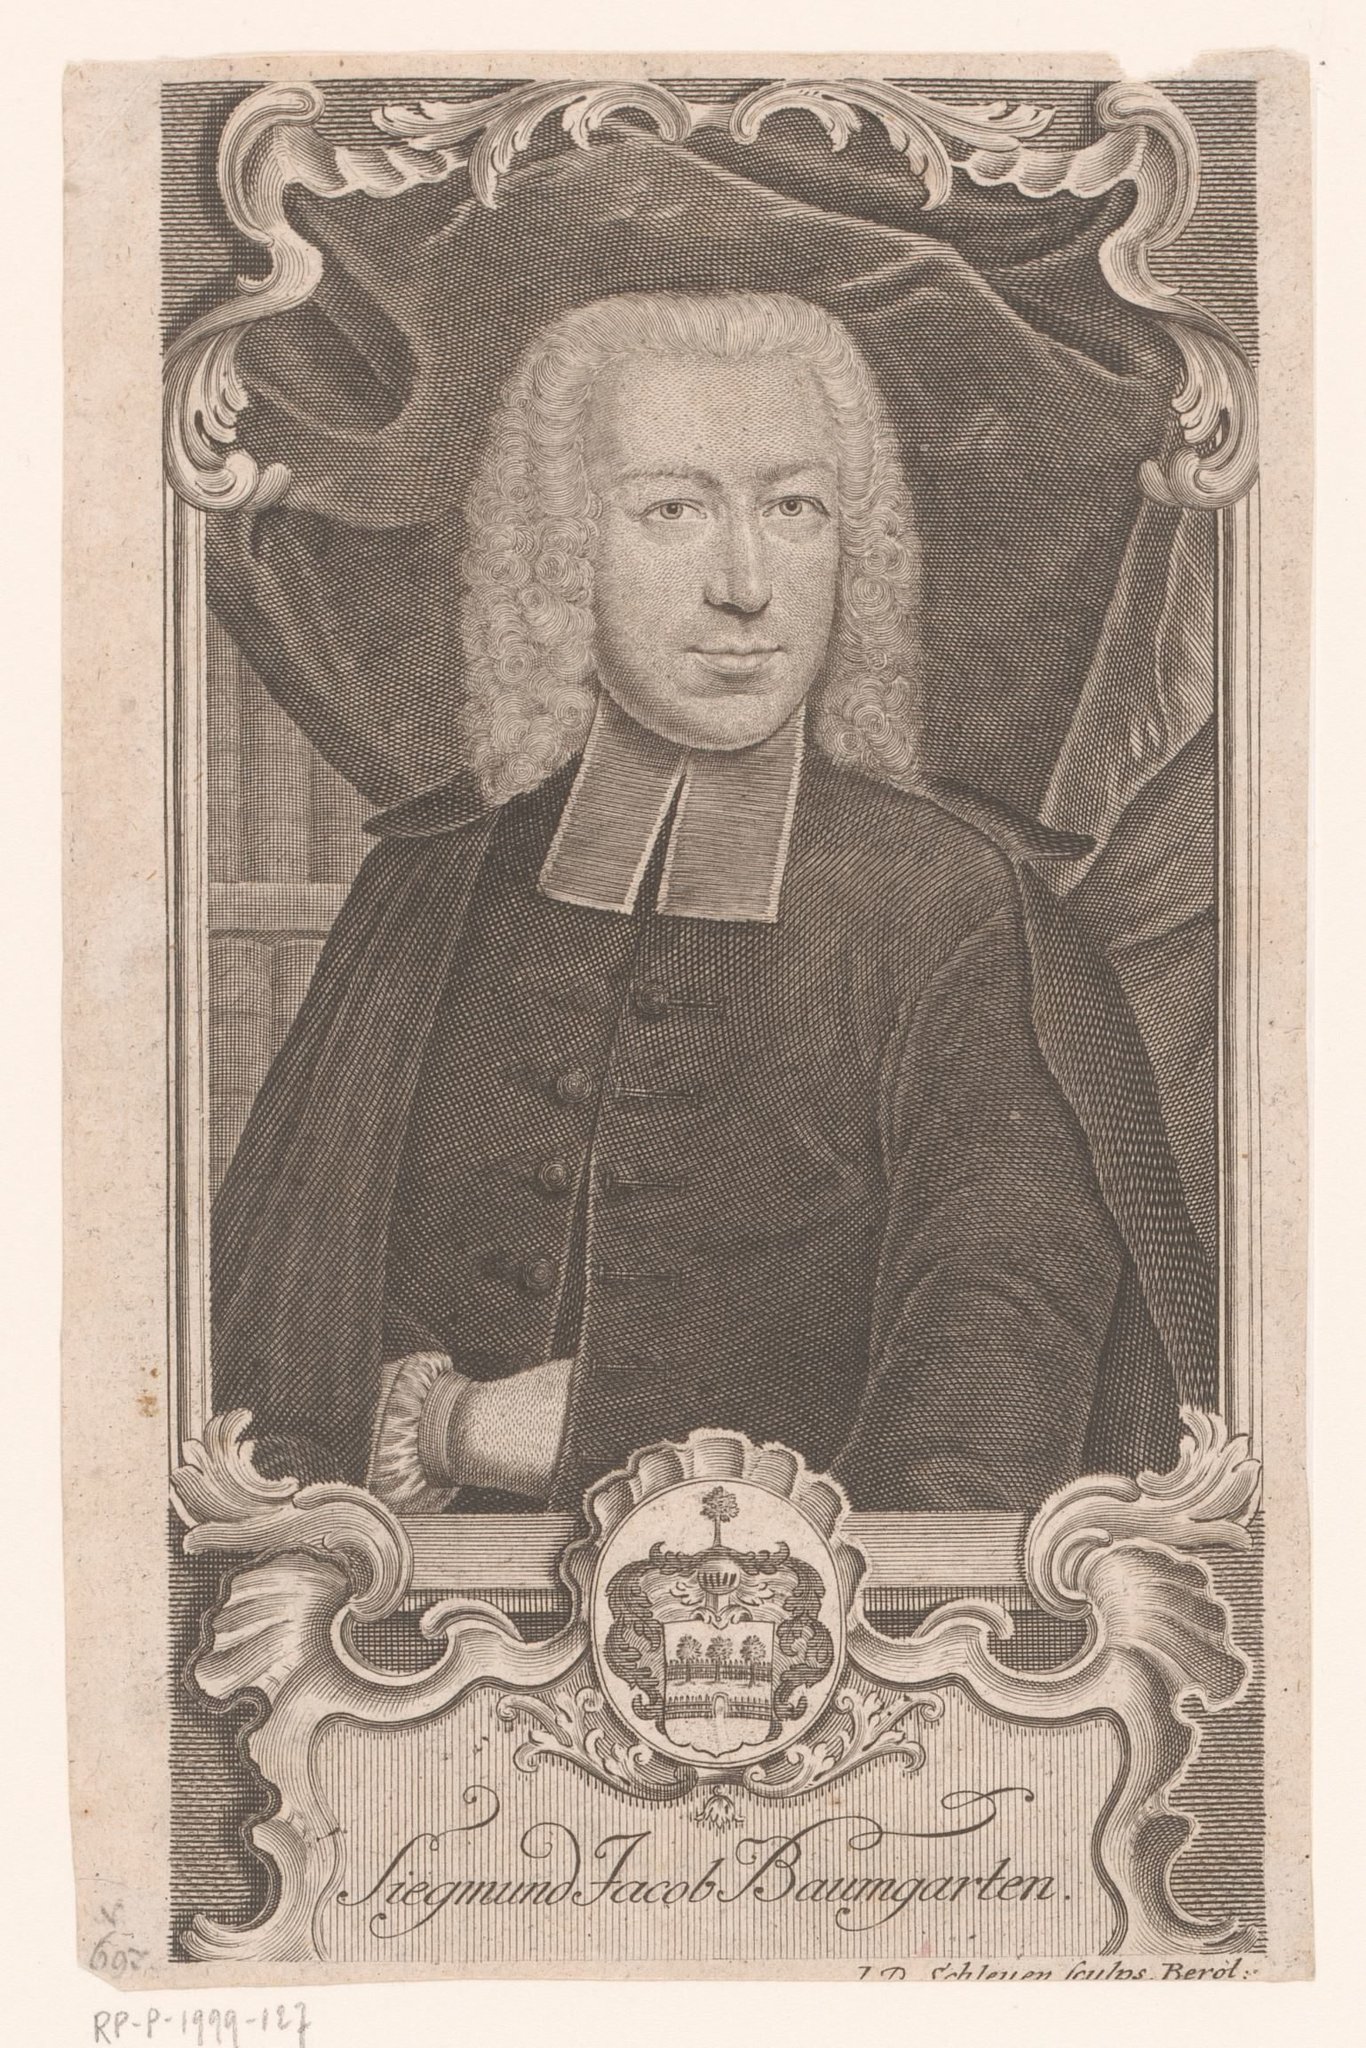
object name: print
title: Portret van Sigmund Jacob Baumgarten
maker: johann david schleuen (i)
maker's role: print maker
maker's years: 1711-1774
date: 1721-1771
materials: paper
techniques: engraving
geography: berlin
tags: historical persons, armorial bearing, heraldry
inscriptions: collector's mark: Lugt 2228, collector's mark: Lugt 2760